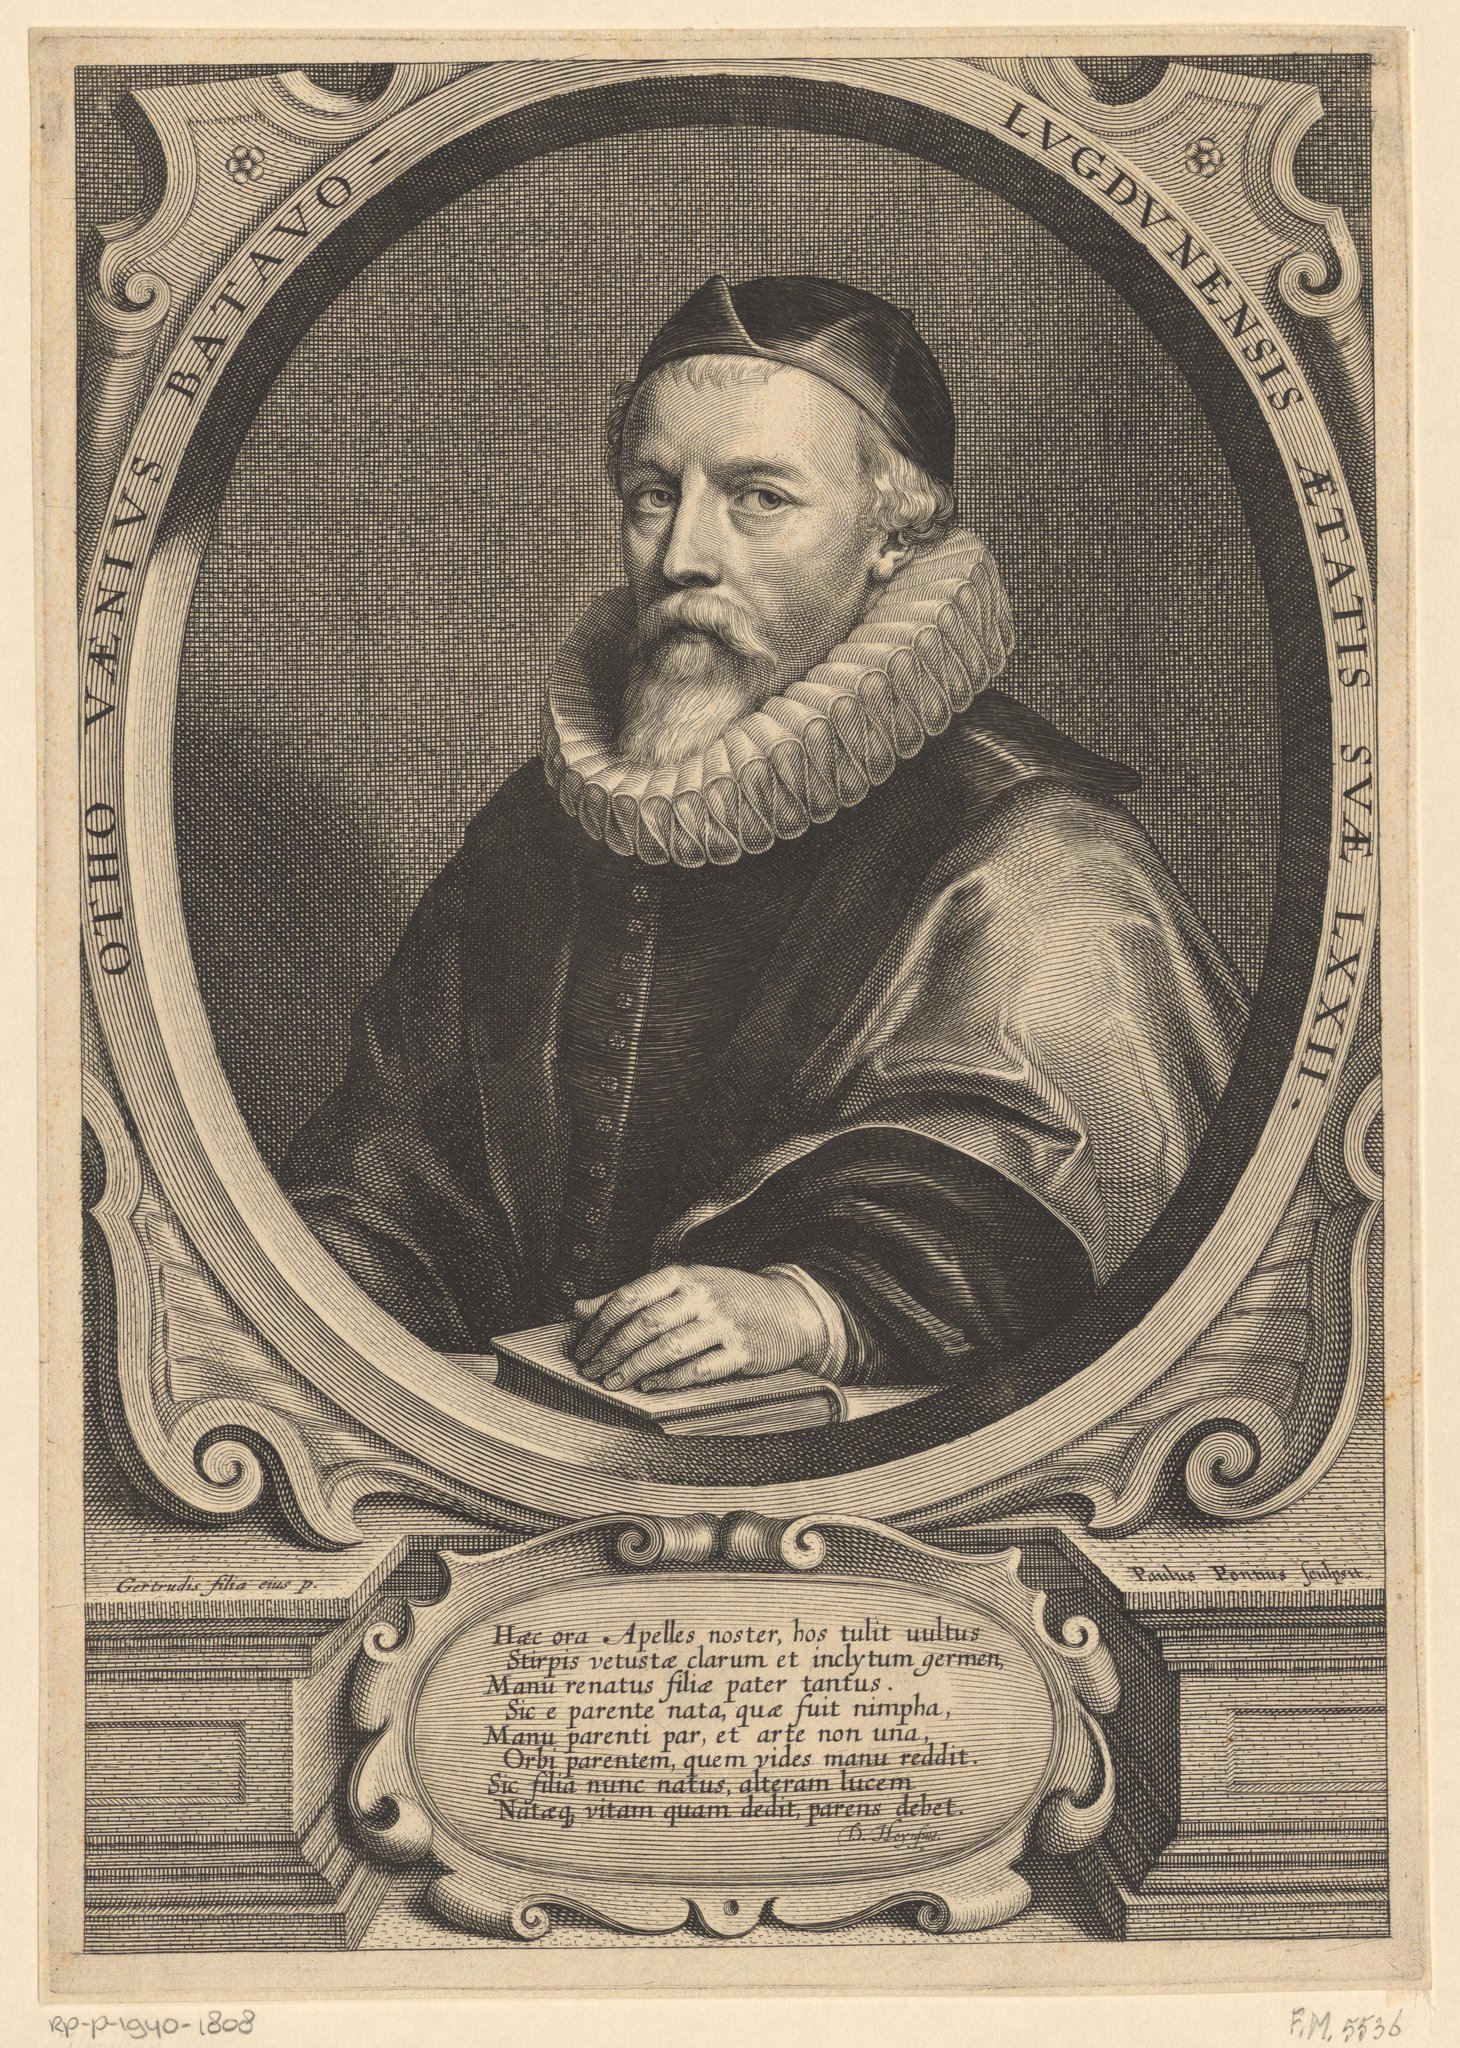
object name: print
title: Portret van Otto van Veen op 72-jarige leeftijd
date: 1628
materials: paper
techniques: engraving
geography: antwerp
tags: leiden, brussels, painter, draughtsman, otto van veen, historical persons, portrait, self-portrait of painter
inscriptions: collector's mark: Lugt 2760, collector's mark: Lugt 2228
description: Met achtregelig onderschrift in het Latijn.